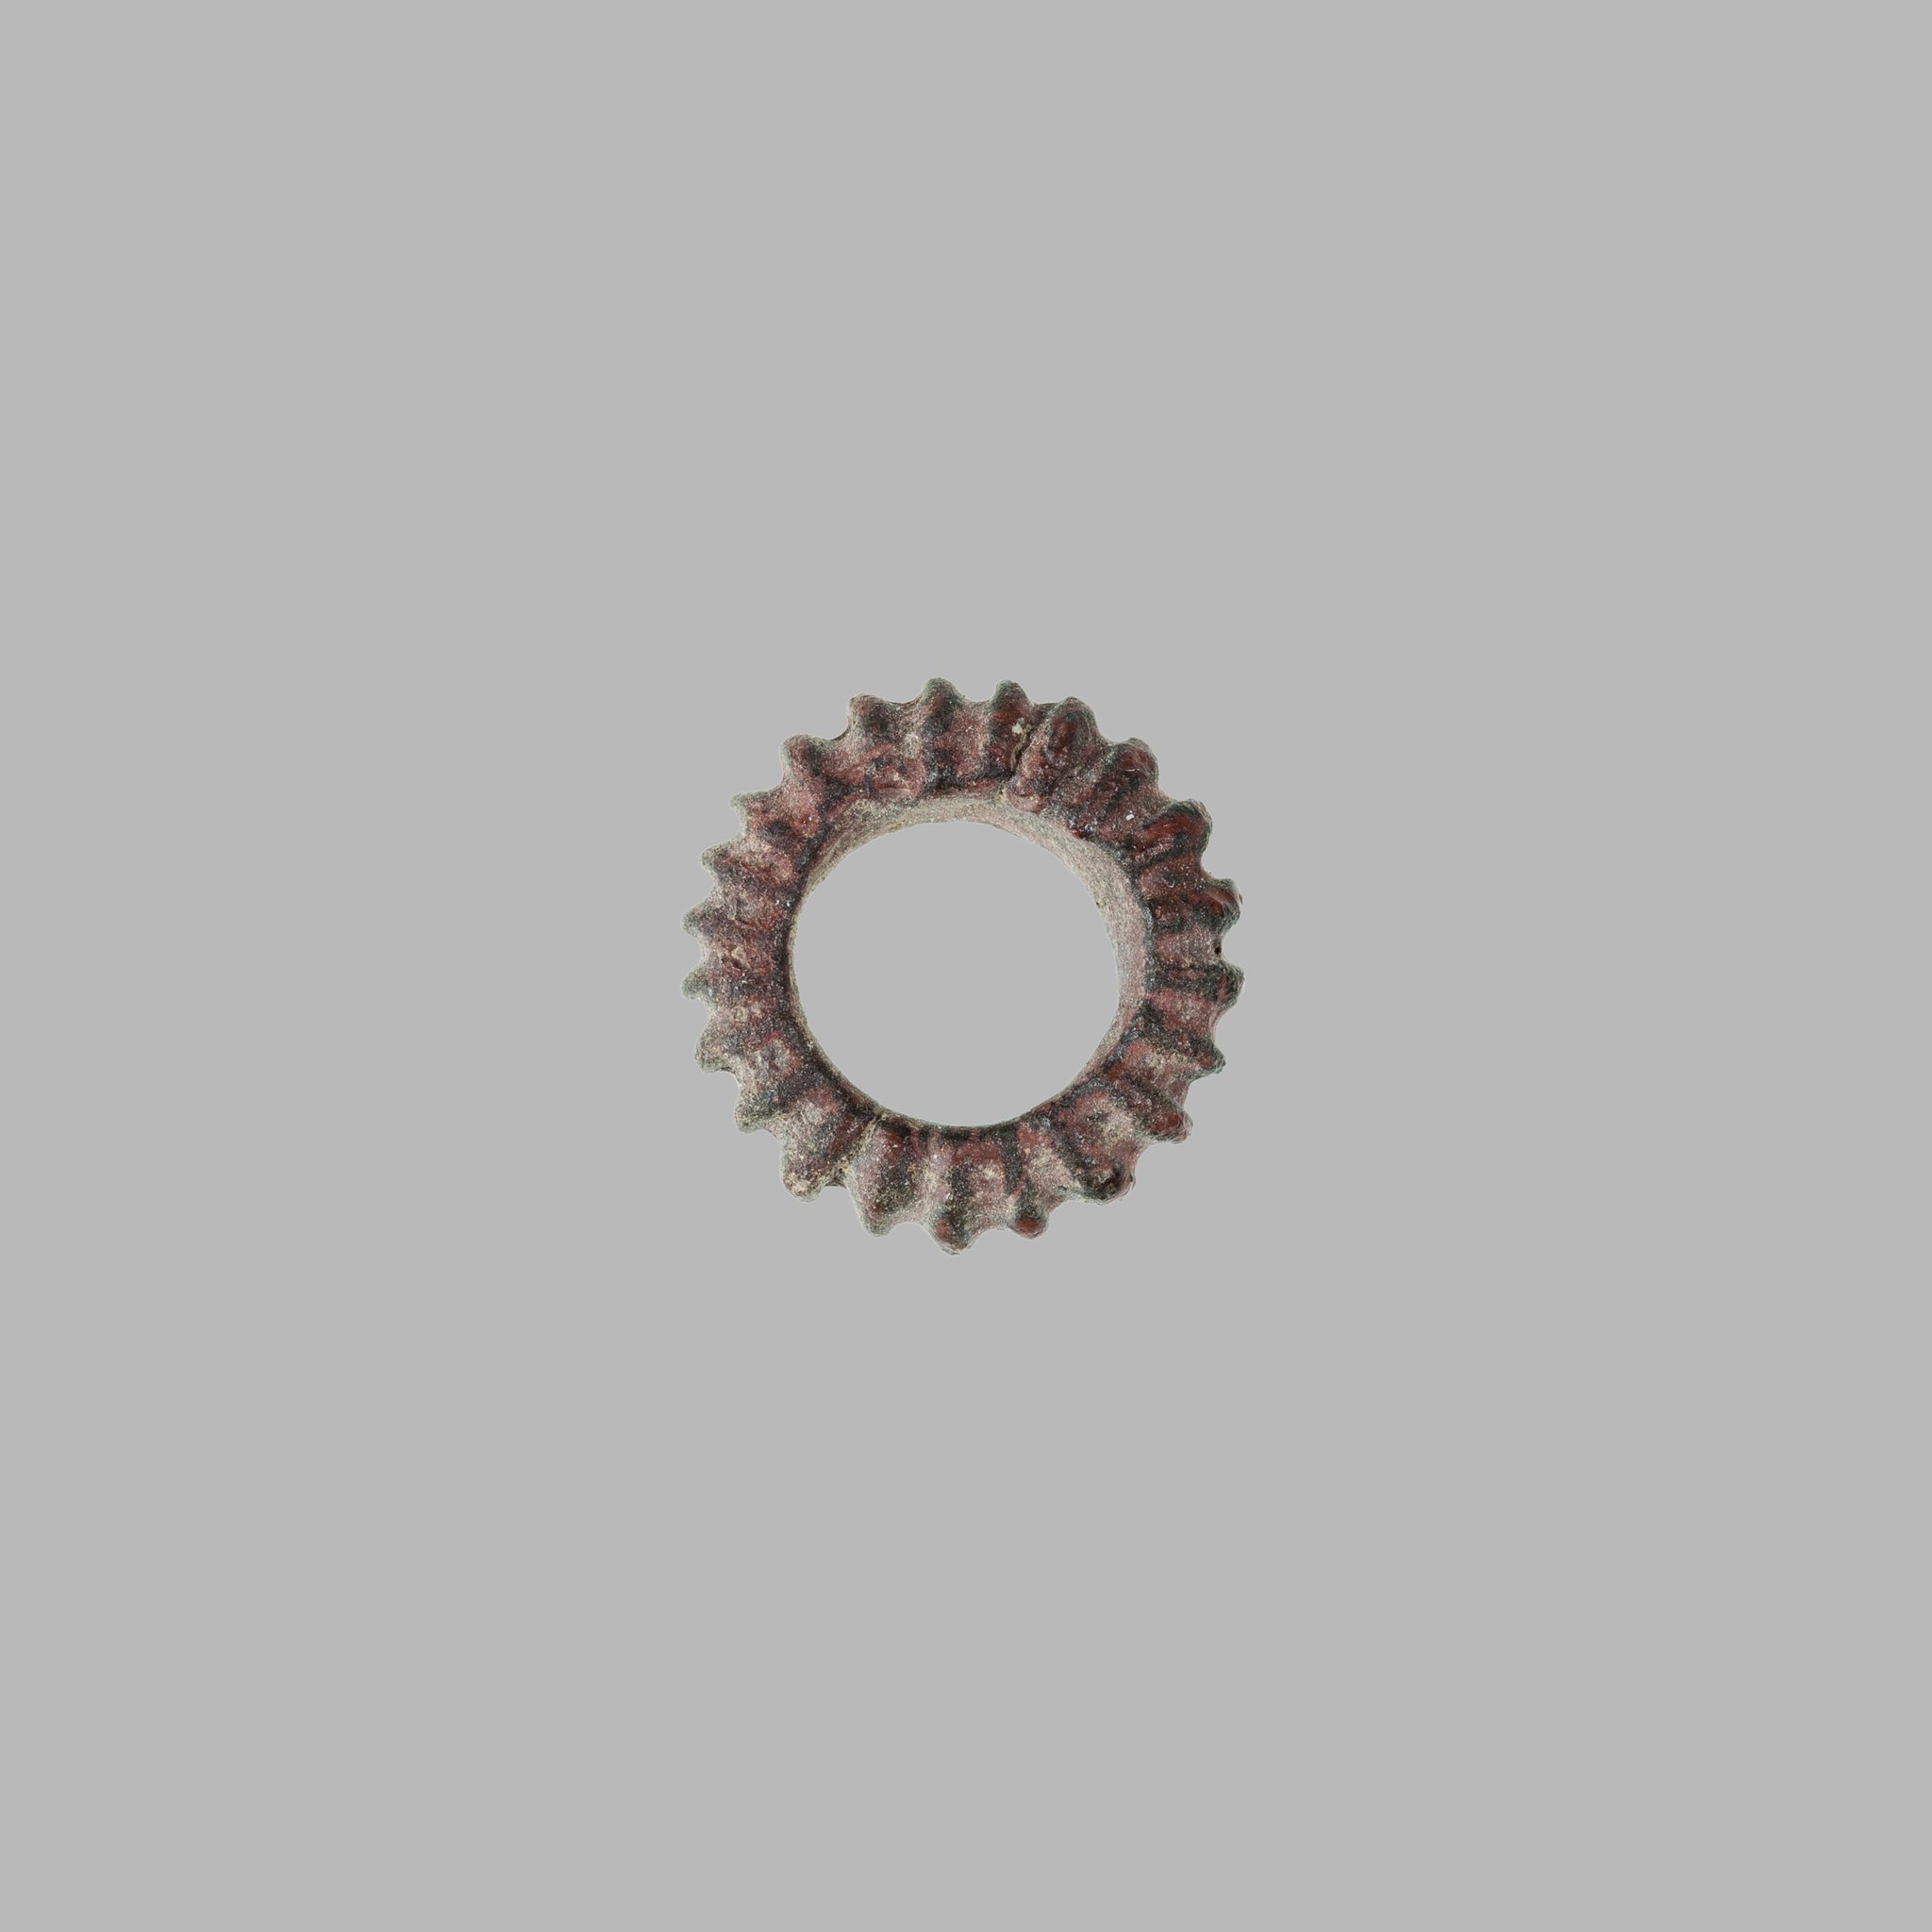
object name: pendant, rosette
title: Rosette Pendant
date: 1353-1336 BCE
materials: faience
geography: egypt